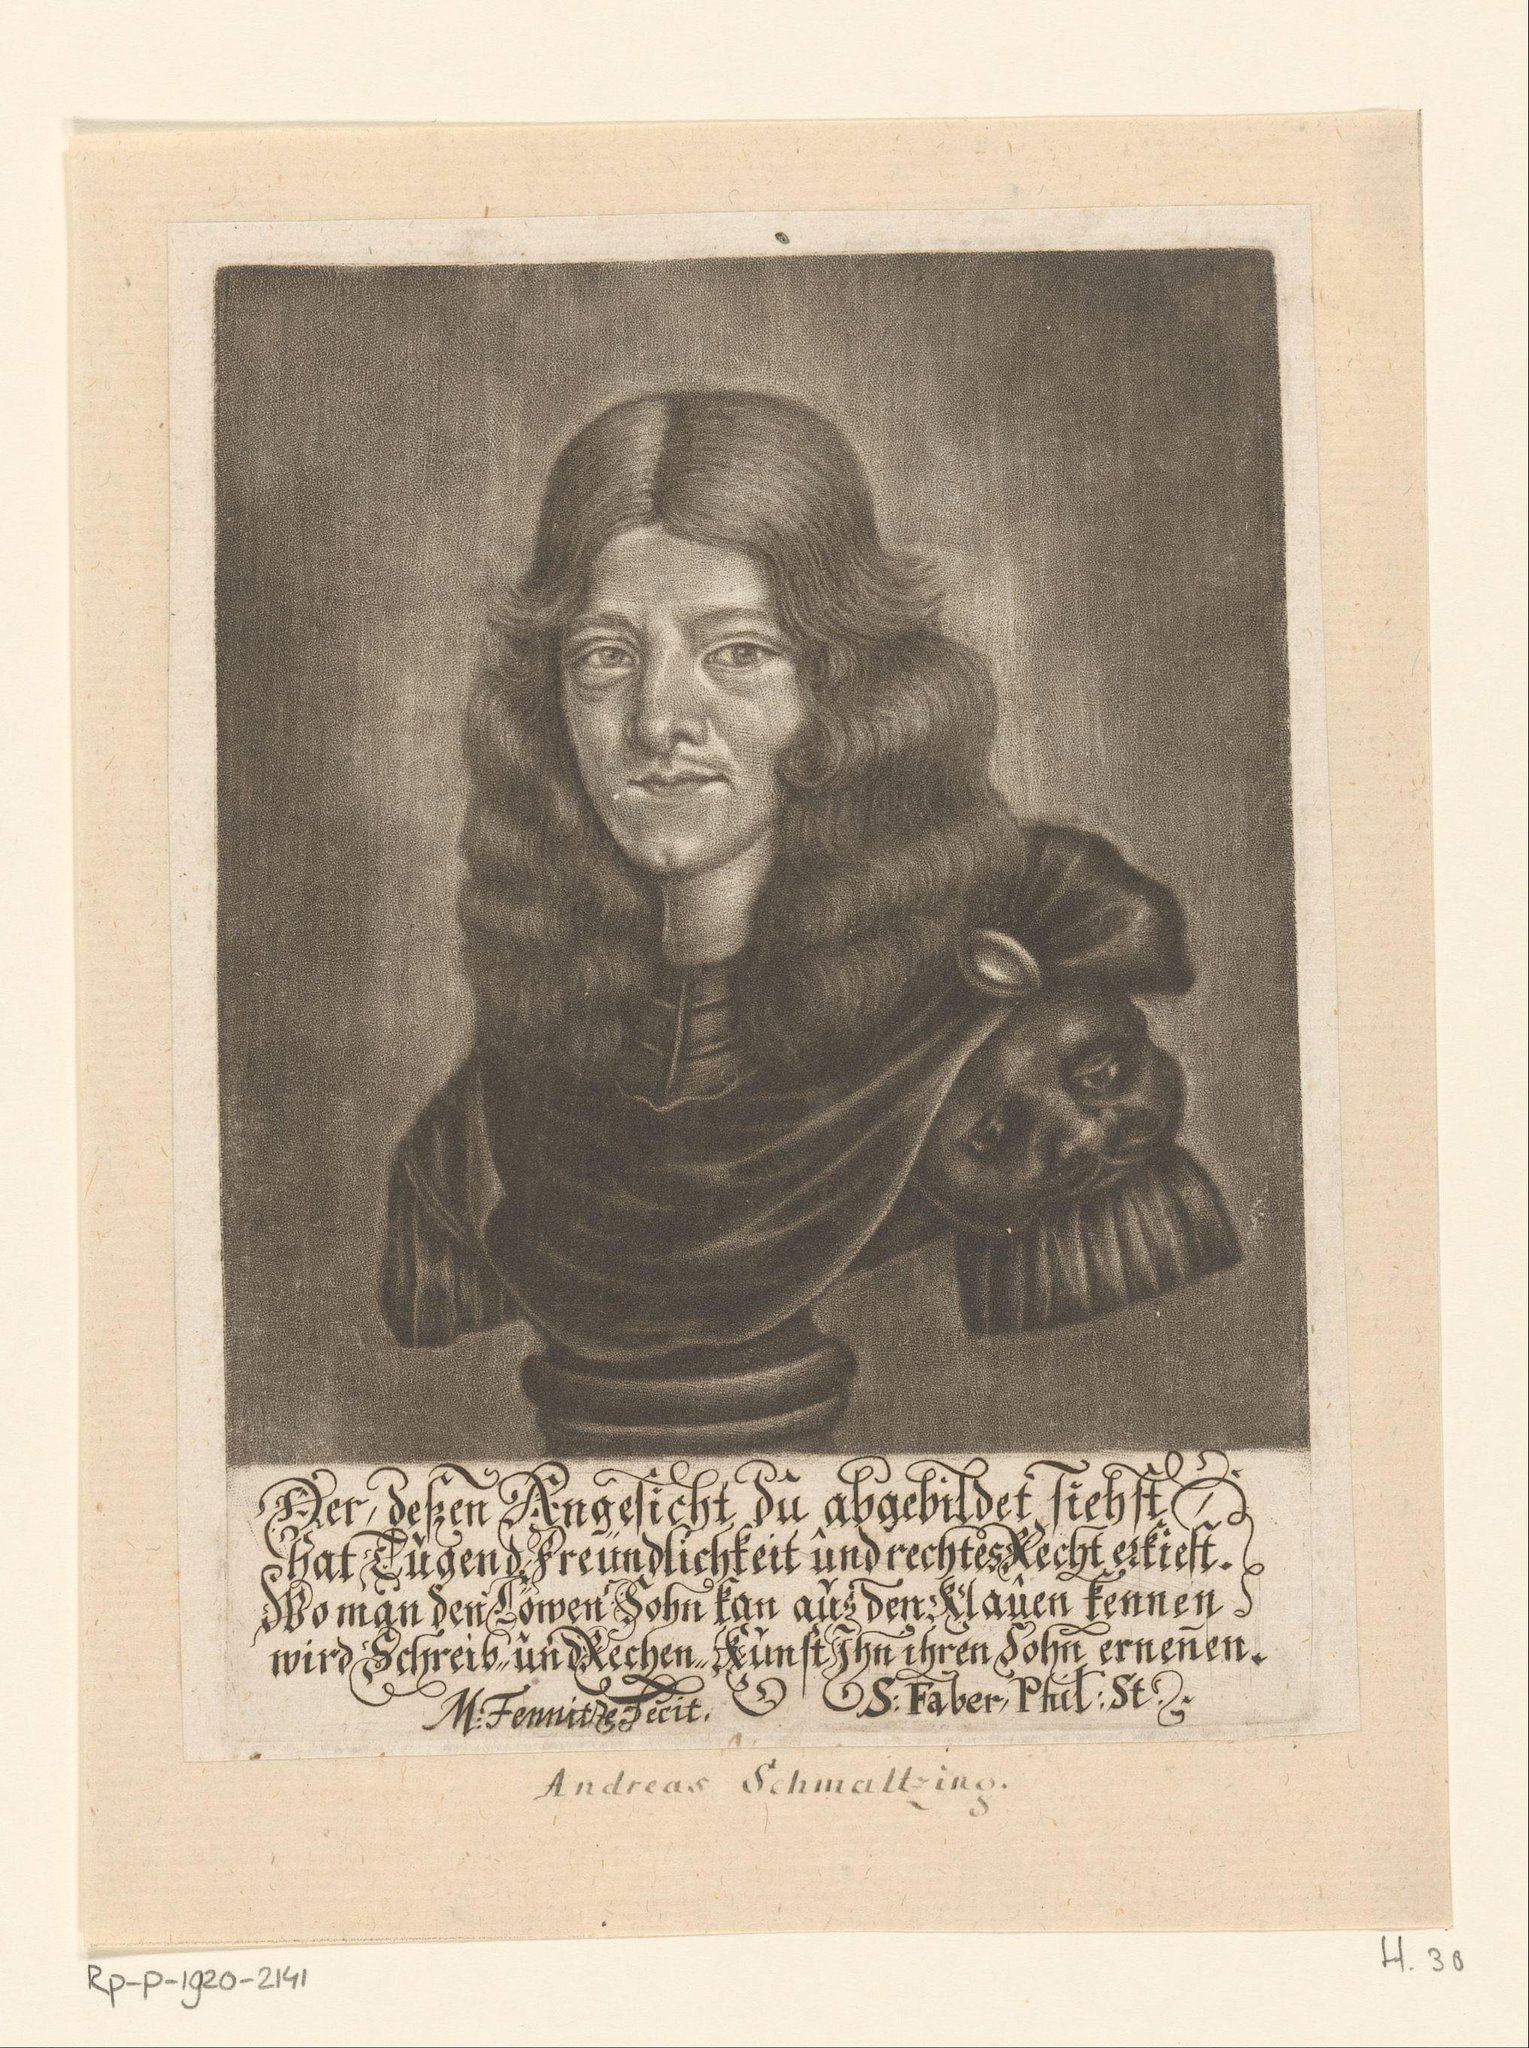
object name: print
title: Portret van Andreas Schmaltzing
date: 1651-1702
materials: paper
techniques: mezzotint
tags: chest, bust, historical persons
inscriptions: collector's mark: Lugt 2228